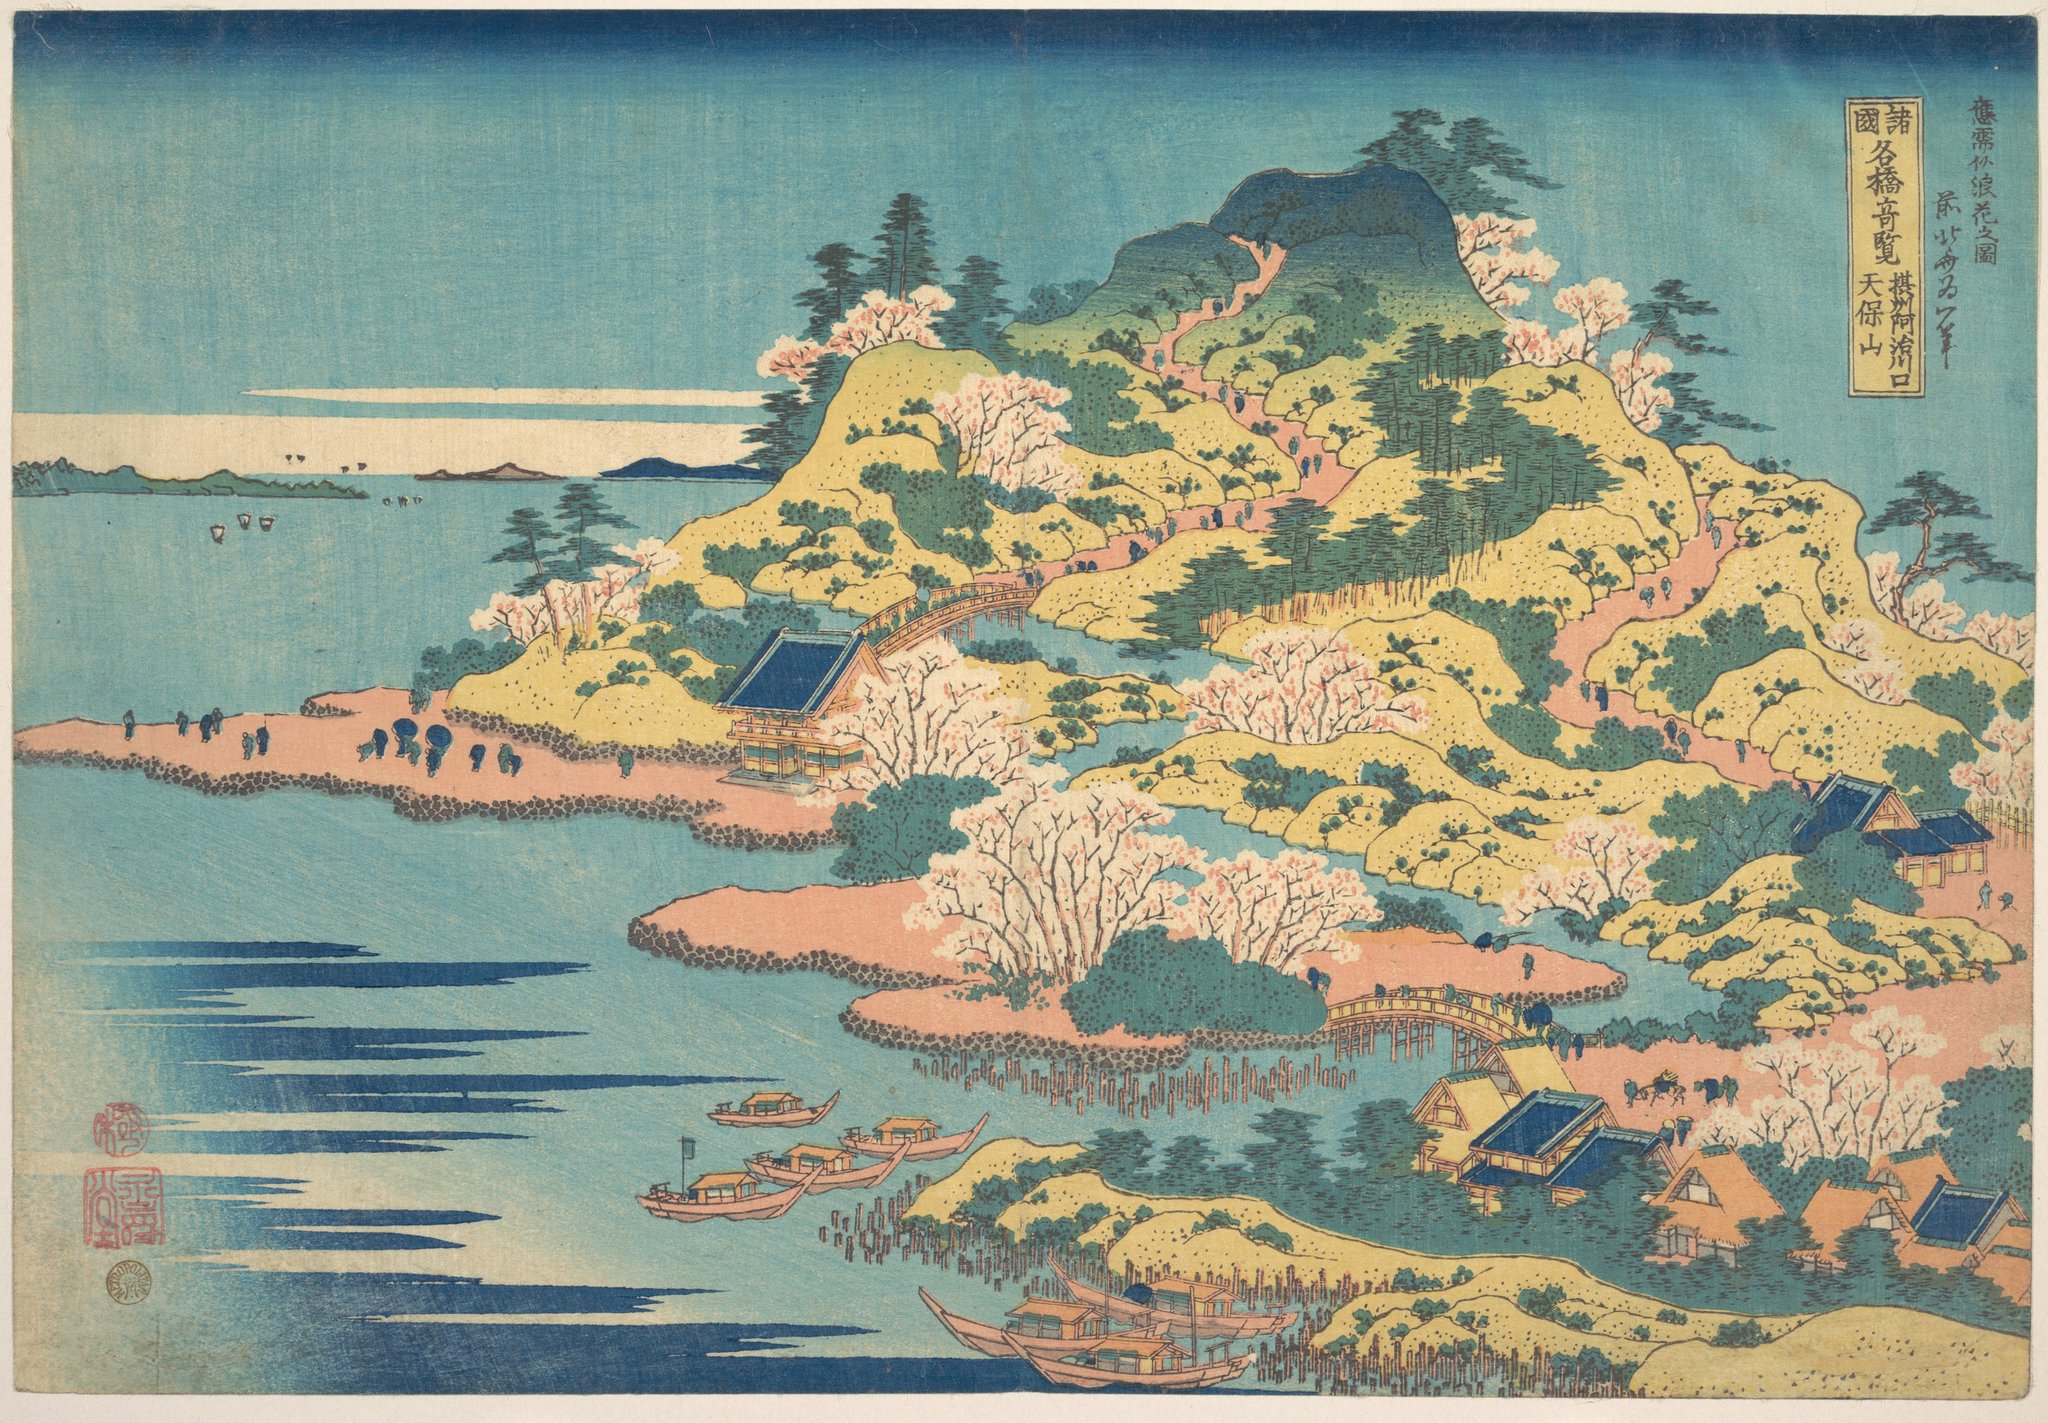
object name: woodblock print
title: Tenpōzan at the Mouth of the Aji River in Settsu Province (Sesshū Ajikawaguchi Tenpōzan), from the series Remarkable Views of Bridges in Various Provinces (Shokoku meikyō kiran)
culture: japanese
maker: katsushika hokusai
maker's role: artist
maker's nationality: japanese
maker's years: 1760-1849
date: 1827-1830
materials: ink, paper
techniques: woodblock print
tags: bridges,rivers,trees,boats